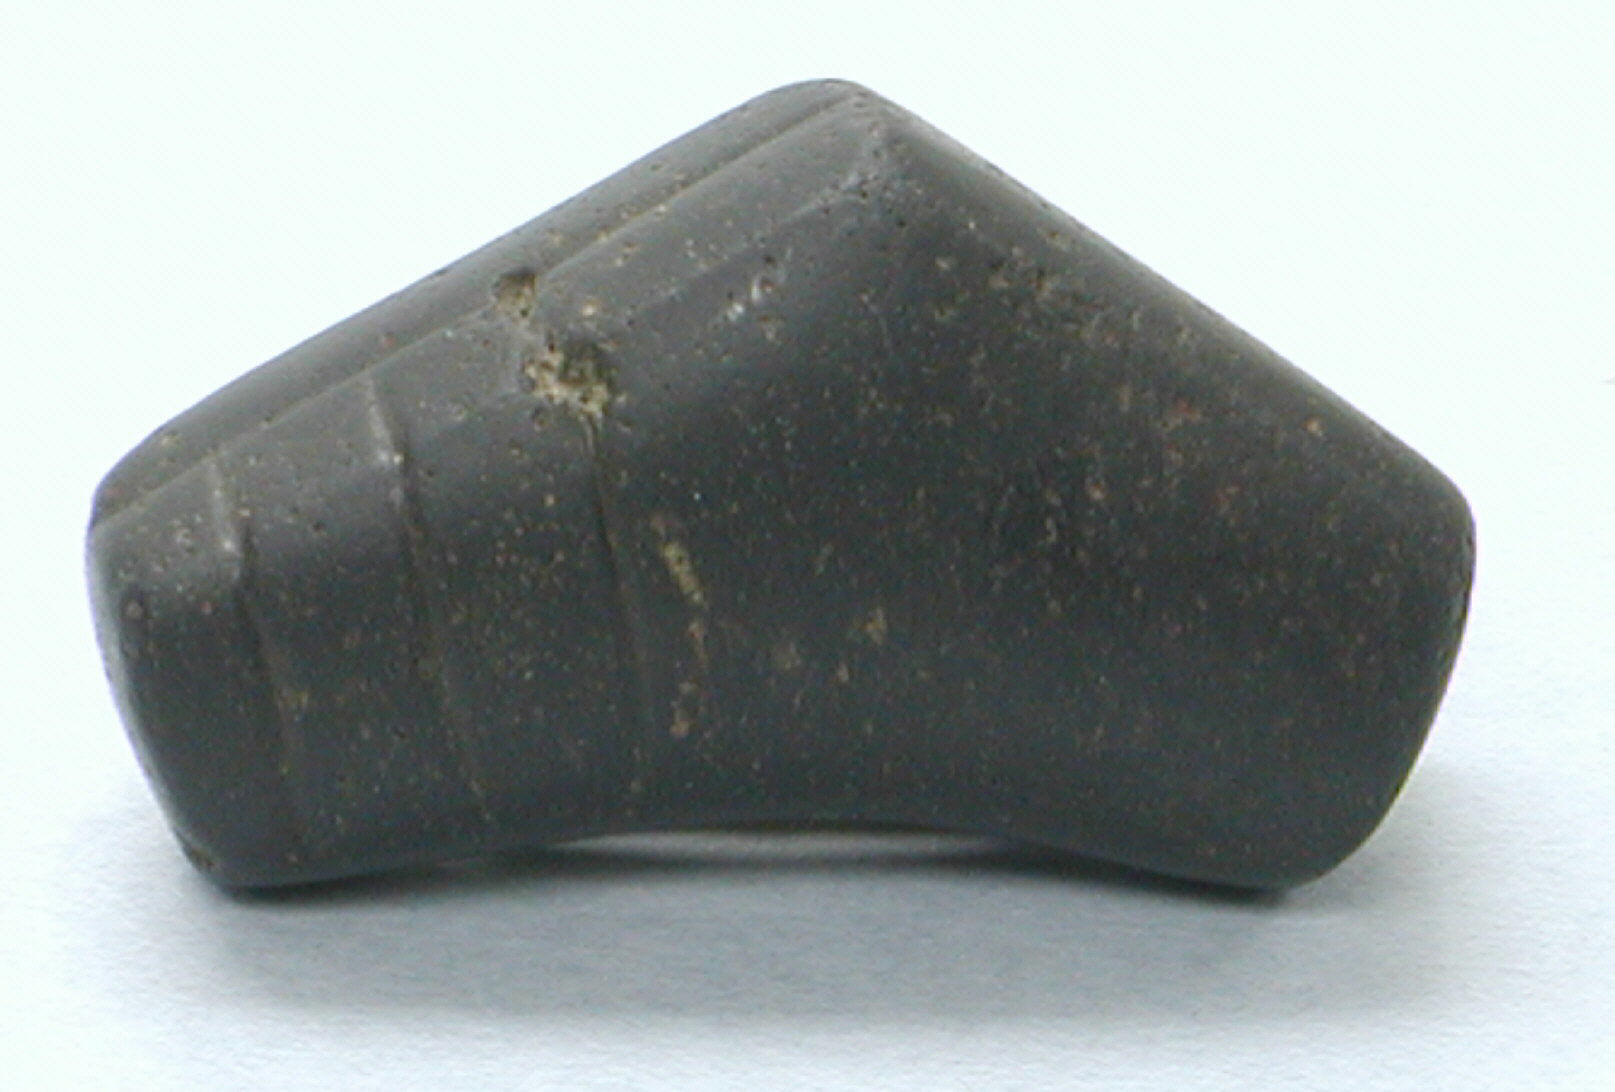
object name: ritual stone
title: Stone Pulidor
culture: mexican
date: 1501-1600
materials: stone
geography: mexico